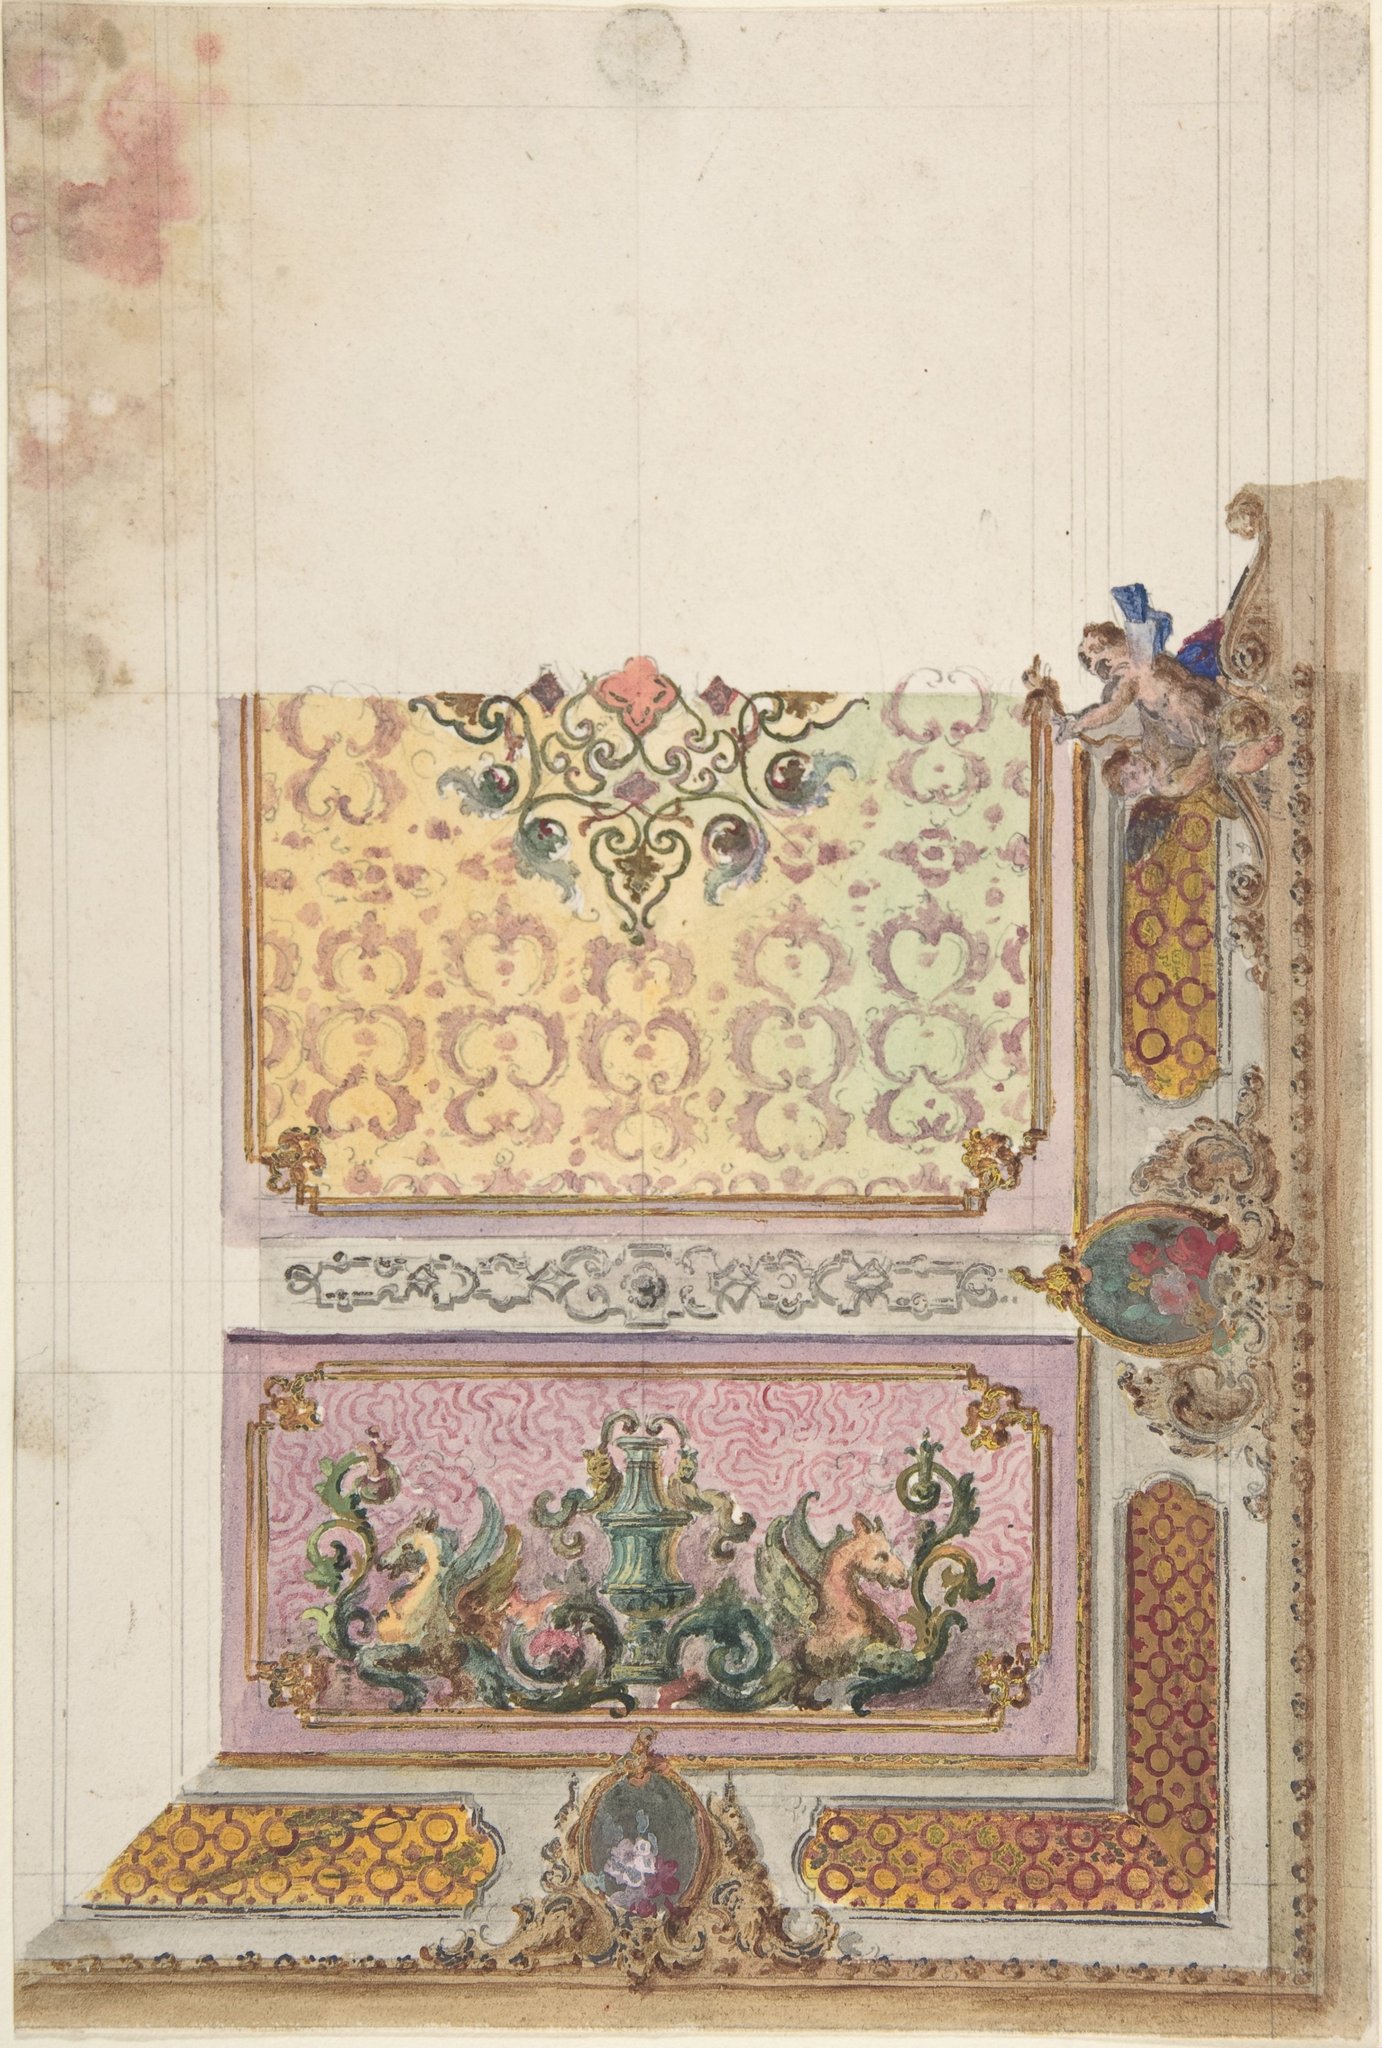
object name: drawing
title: Design for a Painted Ceiling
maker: anonymous, italian, 19th century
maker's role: artist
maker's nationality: italian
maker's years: 1800-1900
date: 1800-1900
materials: watercolor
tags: ceilings